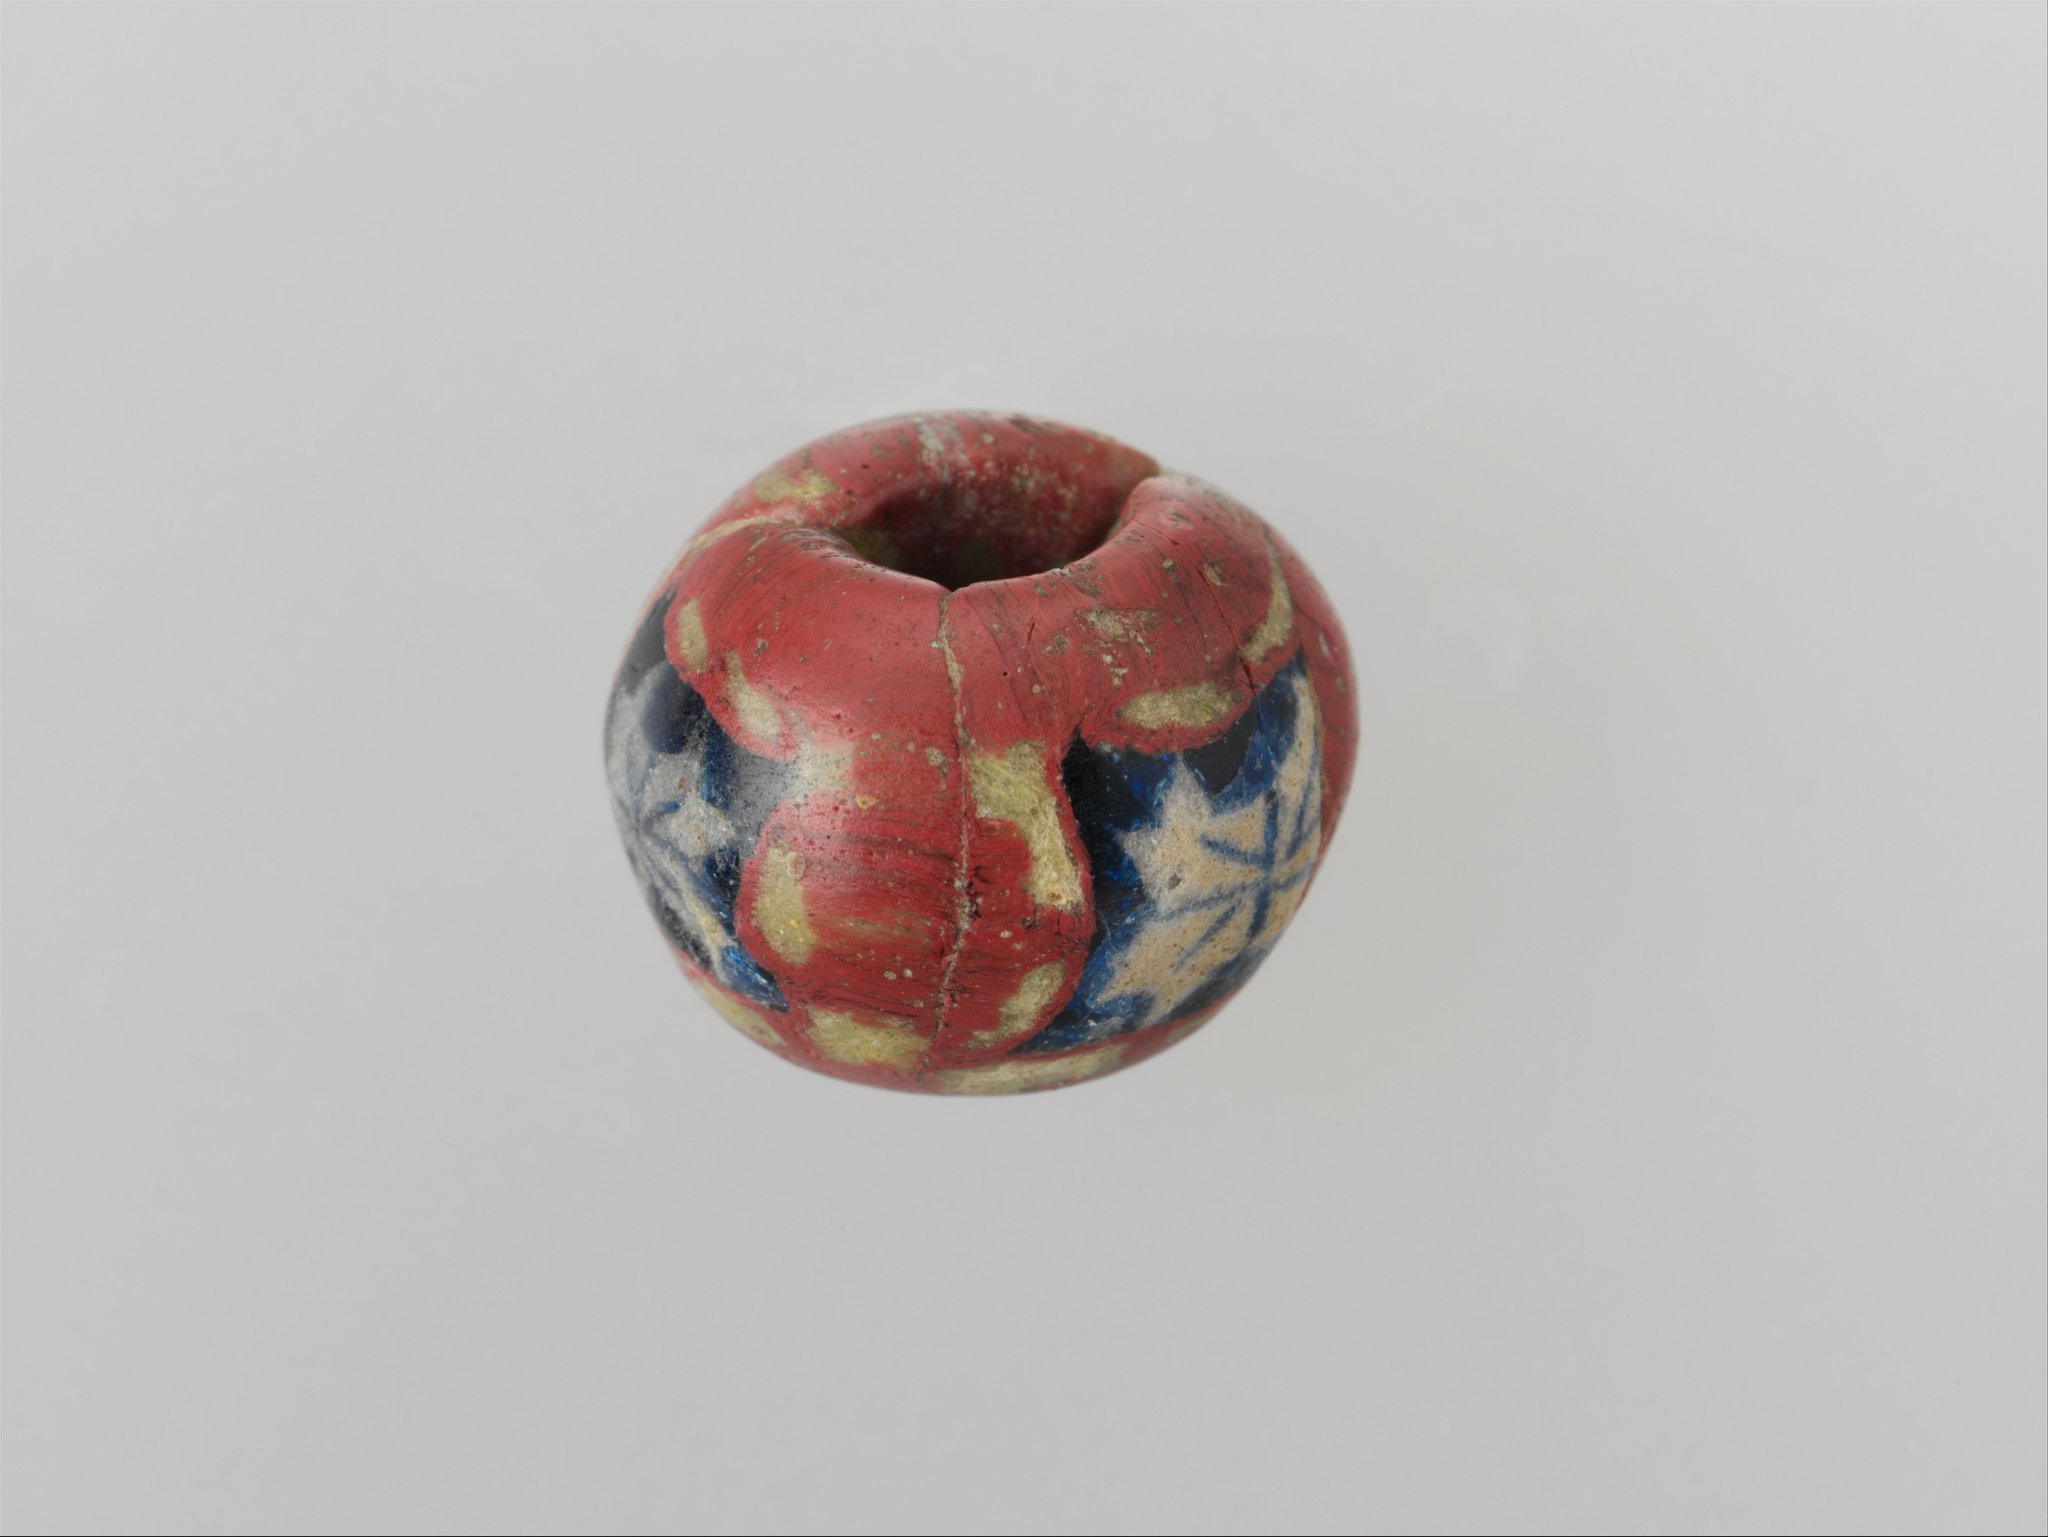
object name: bead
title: Glass mosaic bead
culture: roman, egyptian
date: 1-100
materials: glass